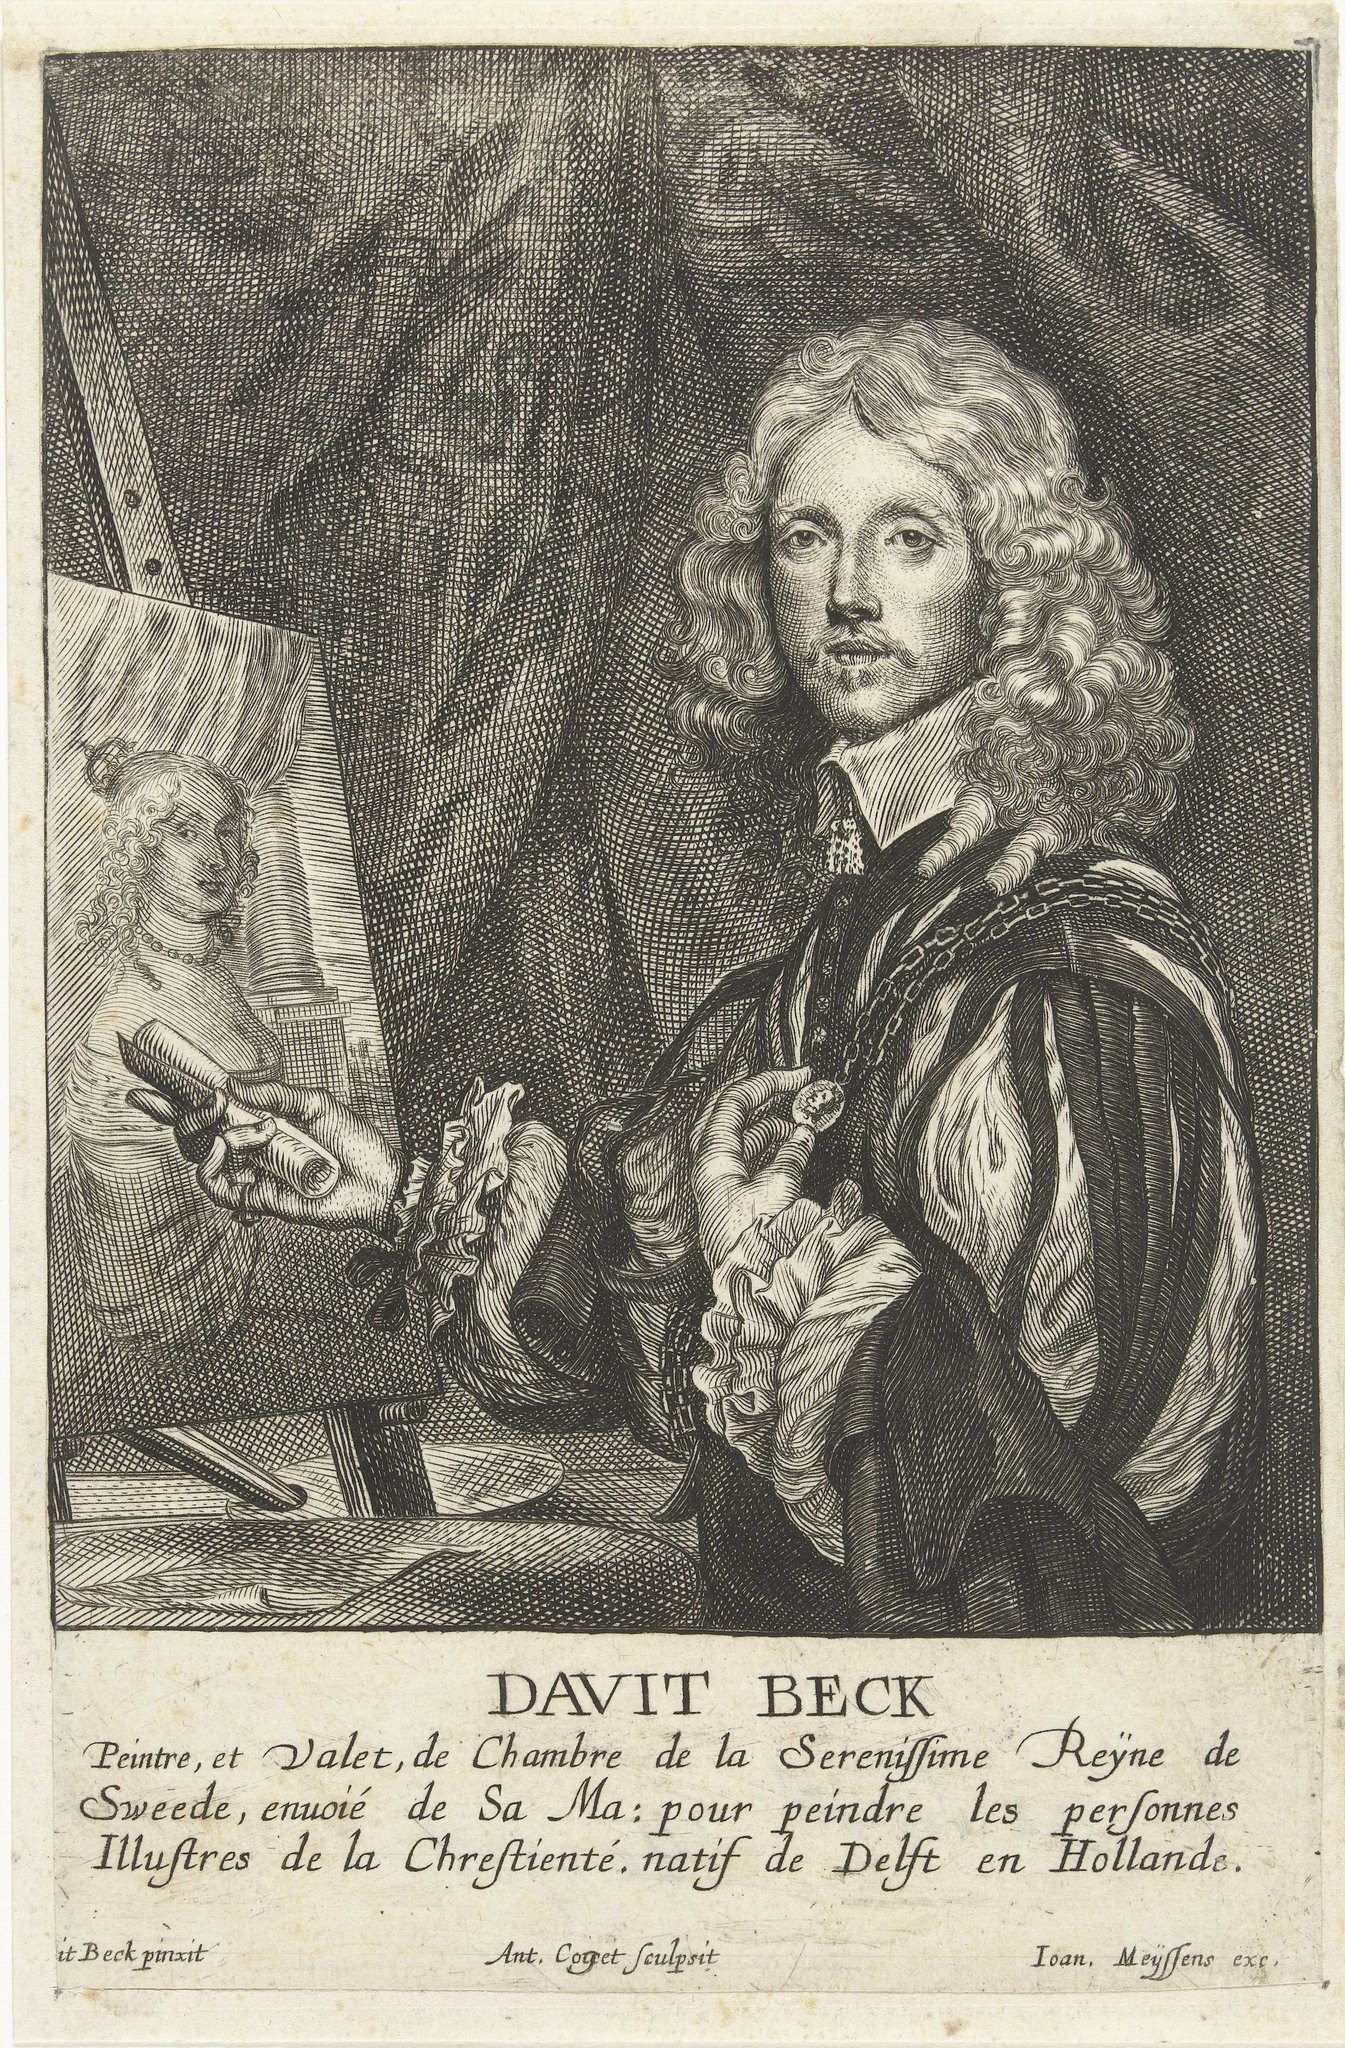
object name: print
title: Portret van de schilder David Beck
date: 1647-1670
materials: paper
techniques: engraving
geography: antwerp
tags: the hague, painter, david beck, portrait, self-portrait of painter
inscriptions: collector's mark: Lugt 2228, collector's mark: Lugt 2760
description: Portret van de Hollandse schilder David Beck in zijn atelier. Beck is aan het werk. Op zijn ezel staat een portret van Christina van Zweden. Met een opgerold papier wijst hij naar het portret, met zijn andere hand toont hij een penning, die hij misschien van Christina heeft ontvangen.